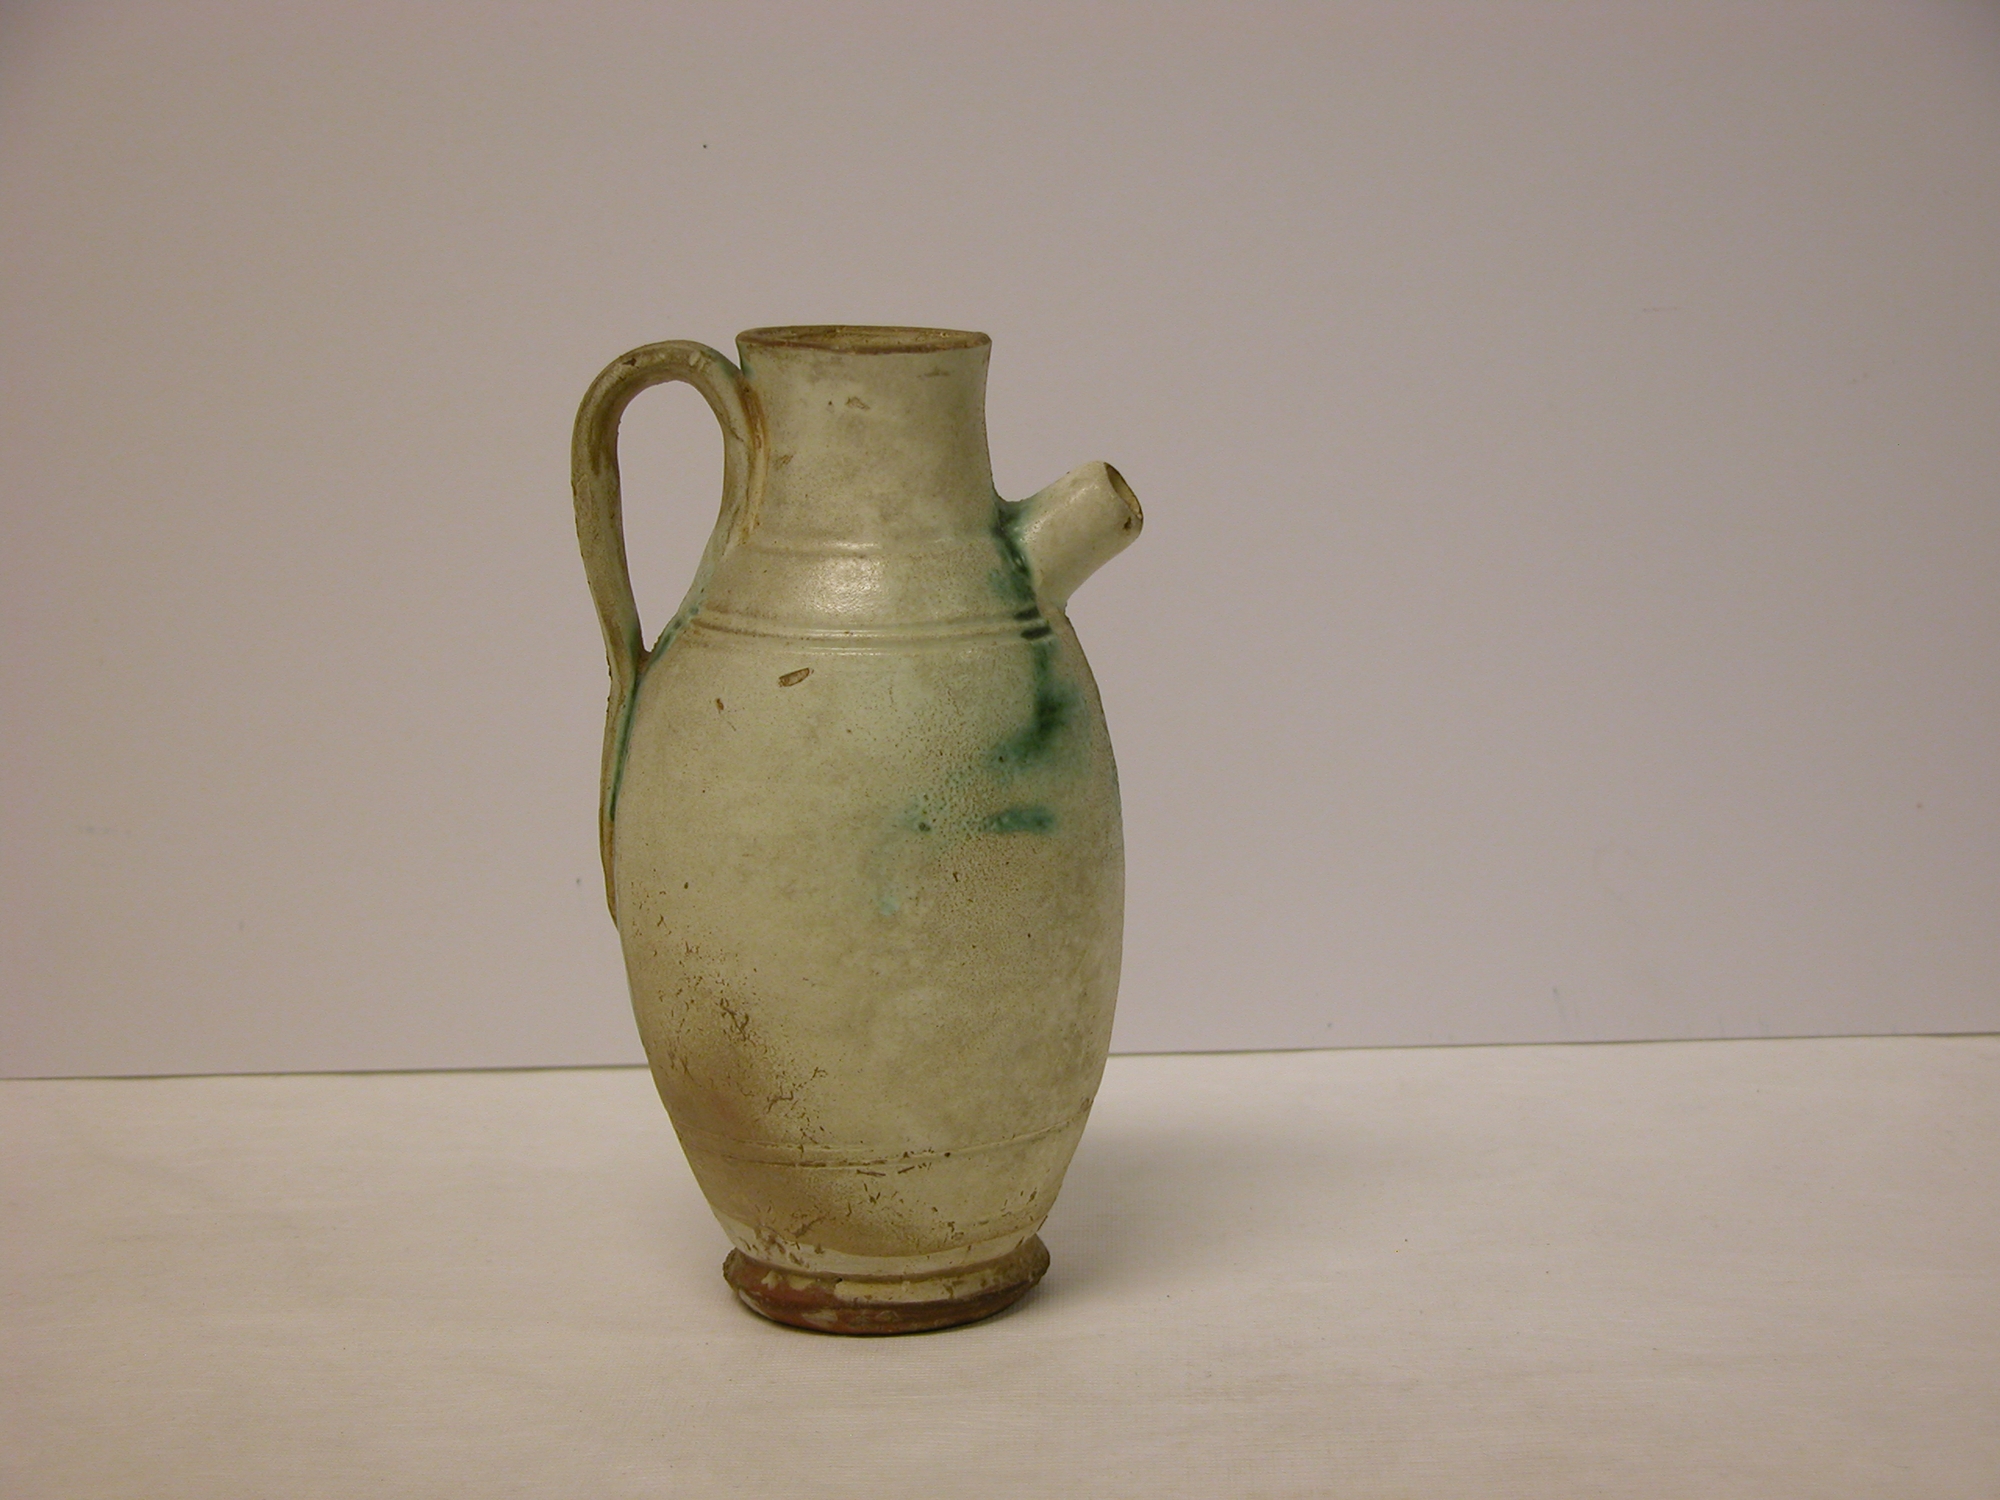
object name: jug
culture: chinese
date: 960-1127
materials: pottery